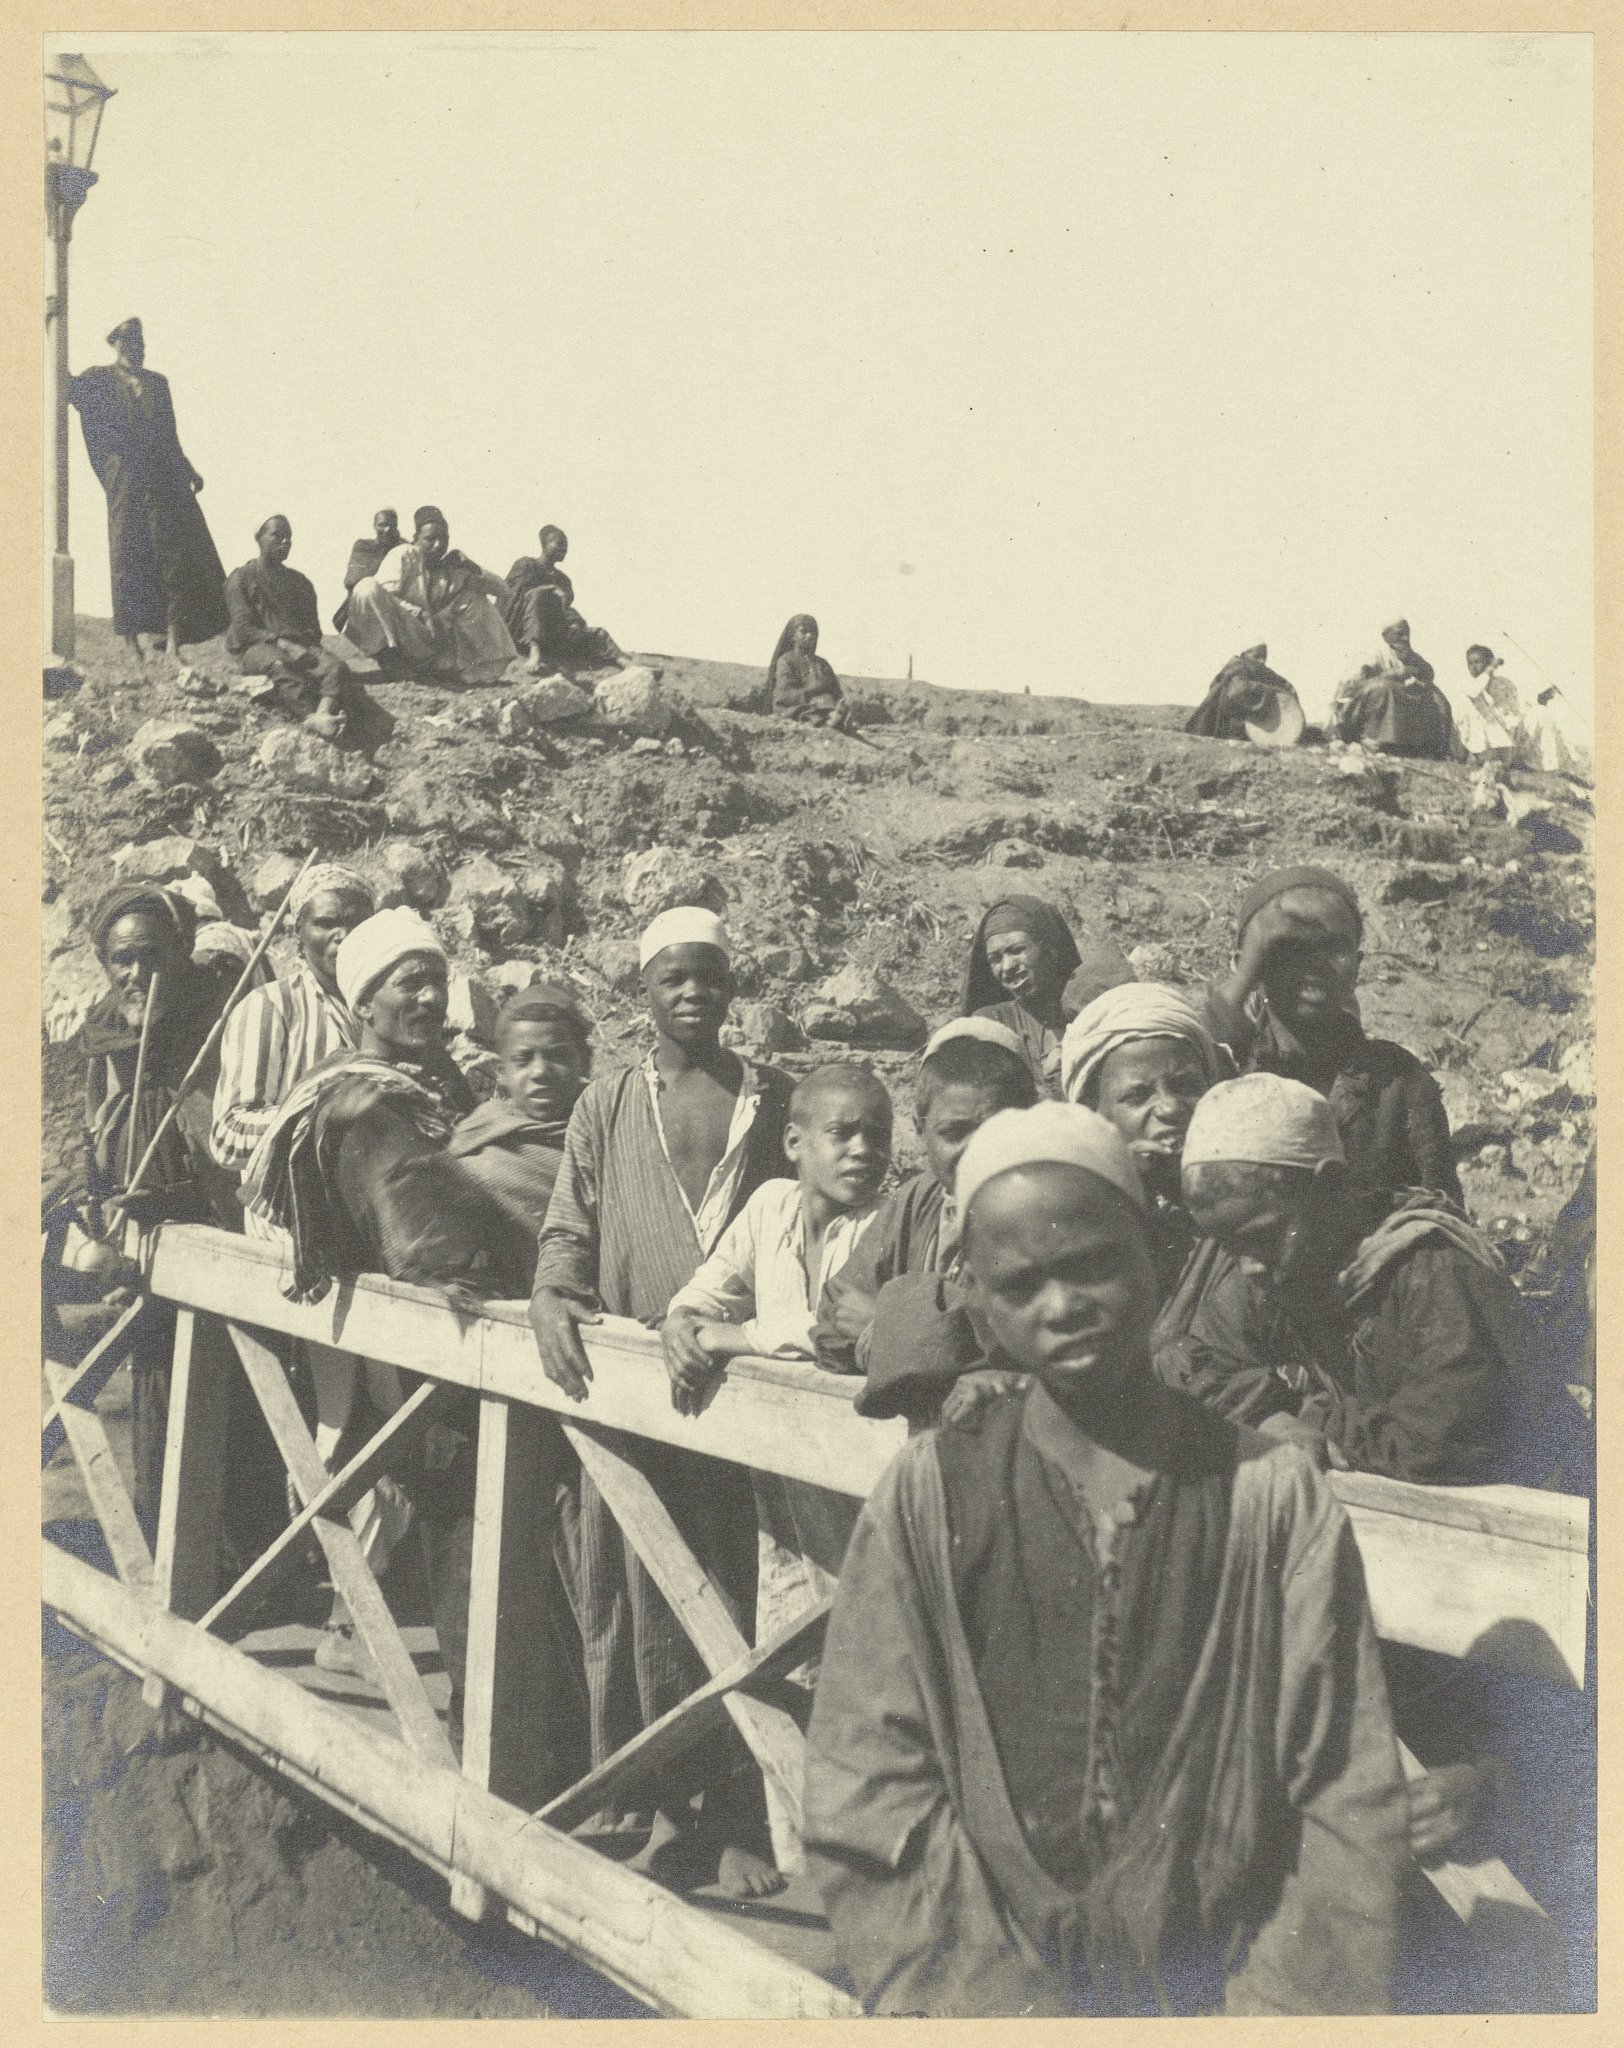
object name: photograph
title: Nubische jongens op de landingsbrug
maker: mr. l. de bruyn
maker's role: fotograaf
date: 1900-1910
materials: paper, cardboard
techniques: gelatin silver print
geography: egypt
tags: african peoples, africans (nubians), youth, adolescent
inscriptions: title: ‘Nubische jongens op de landingsbrug/ door LDB’, stamp: ‘Gemeentelijke bibliotheek/ Rotterdam’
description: Onderdeel van een groep door fotograaf Richard Polak op reis verzamelde foto’s. Deze foto is rond 1910 gemaakt door zijn reisgenoot mr. L. de Bruyn. Foto’s die hij op eerdere reizen verzamelde zijn tentoongesteld bij de Rotterdamsche Kunstkring (1895), Arti en Amicitiae te Amsterdam (1897-1898?) en Societeit 't Collegie te Kampen (datum vooralsnog onbekend). Jongens en mannen beschreven als Nubisch naar aanleiding van de titel op het object.